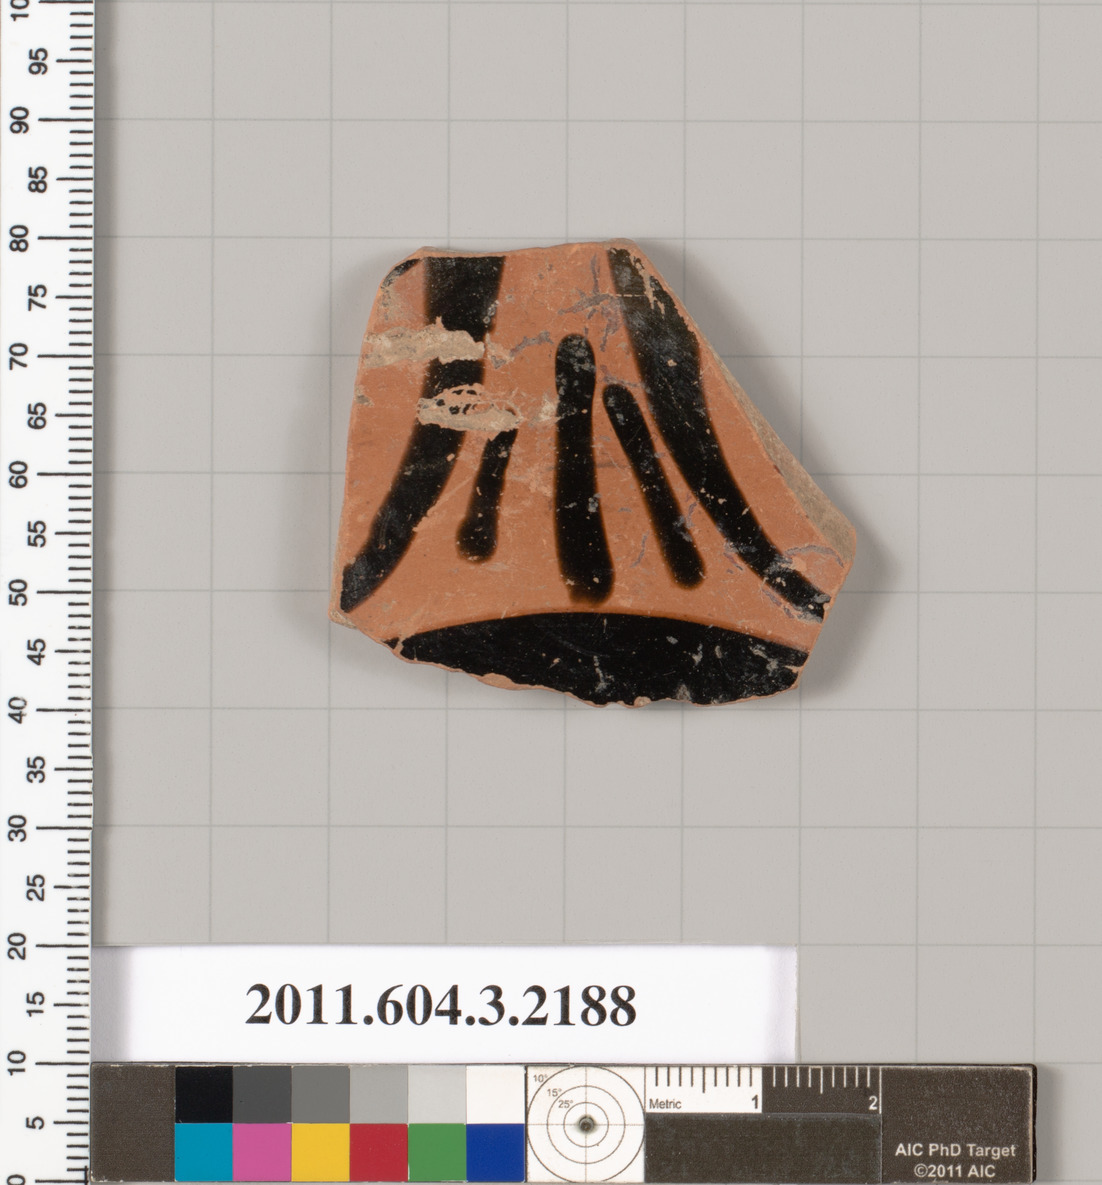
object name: kylix fragment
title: Terracotta fragment of a kylix (drinking cup)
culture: greek, attic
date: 500-468 BCE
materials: terracotta